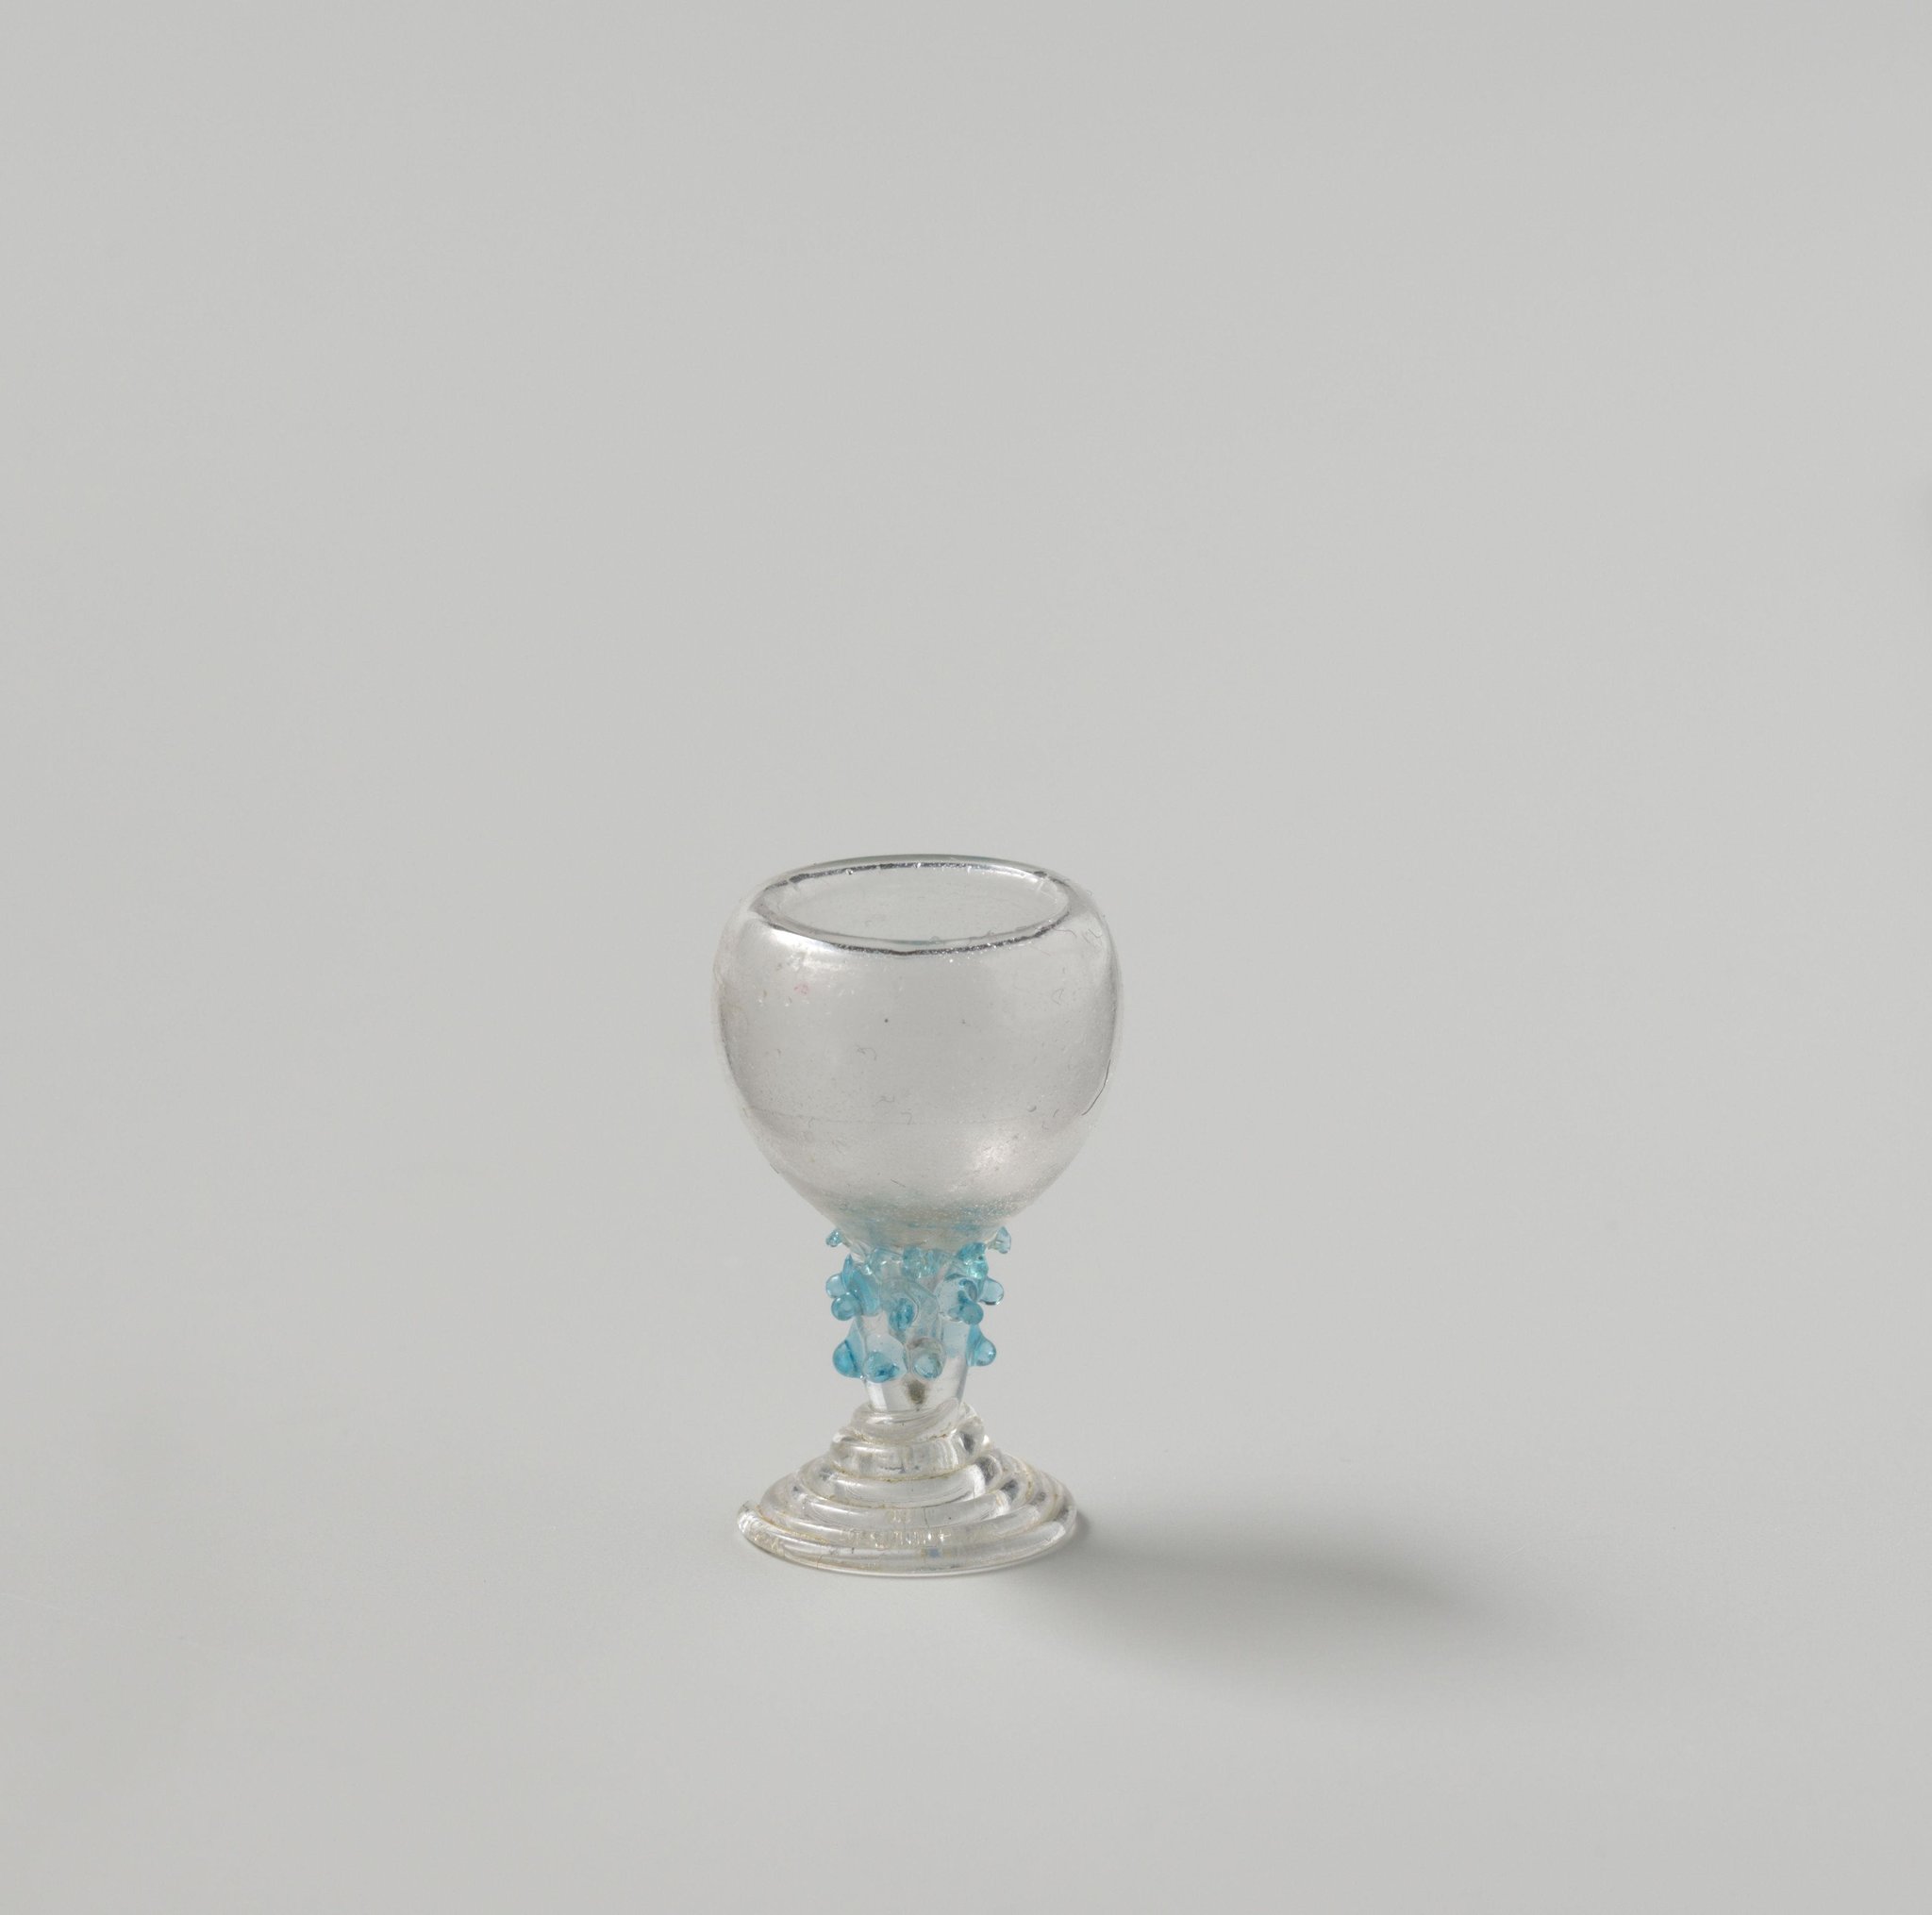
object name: roemer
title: Roemer van helder kleurloos glas met blauwe noppen op de schacht; cuppa dubbelwandig; voet van gespannen glasdraad.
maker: Anonymous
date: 1675-1710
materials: glass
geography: amsterdam